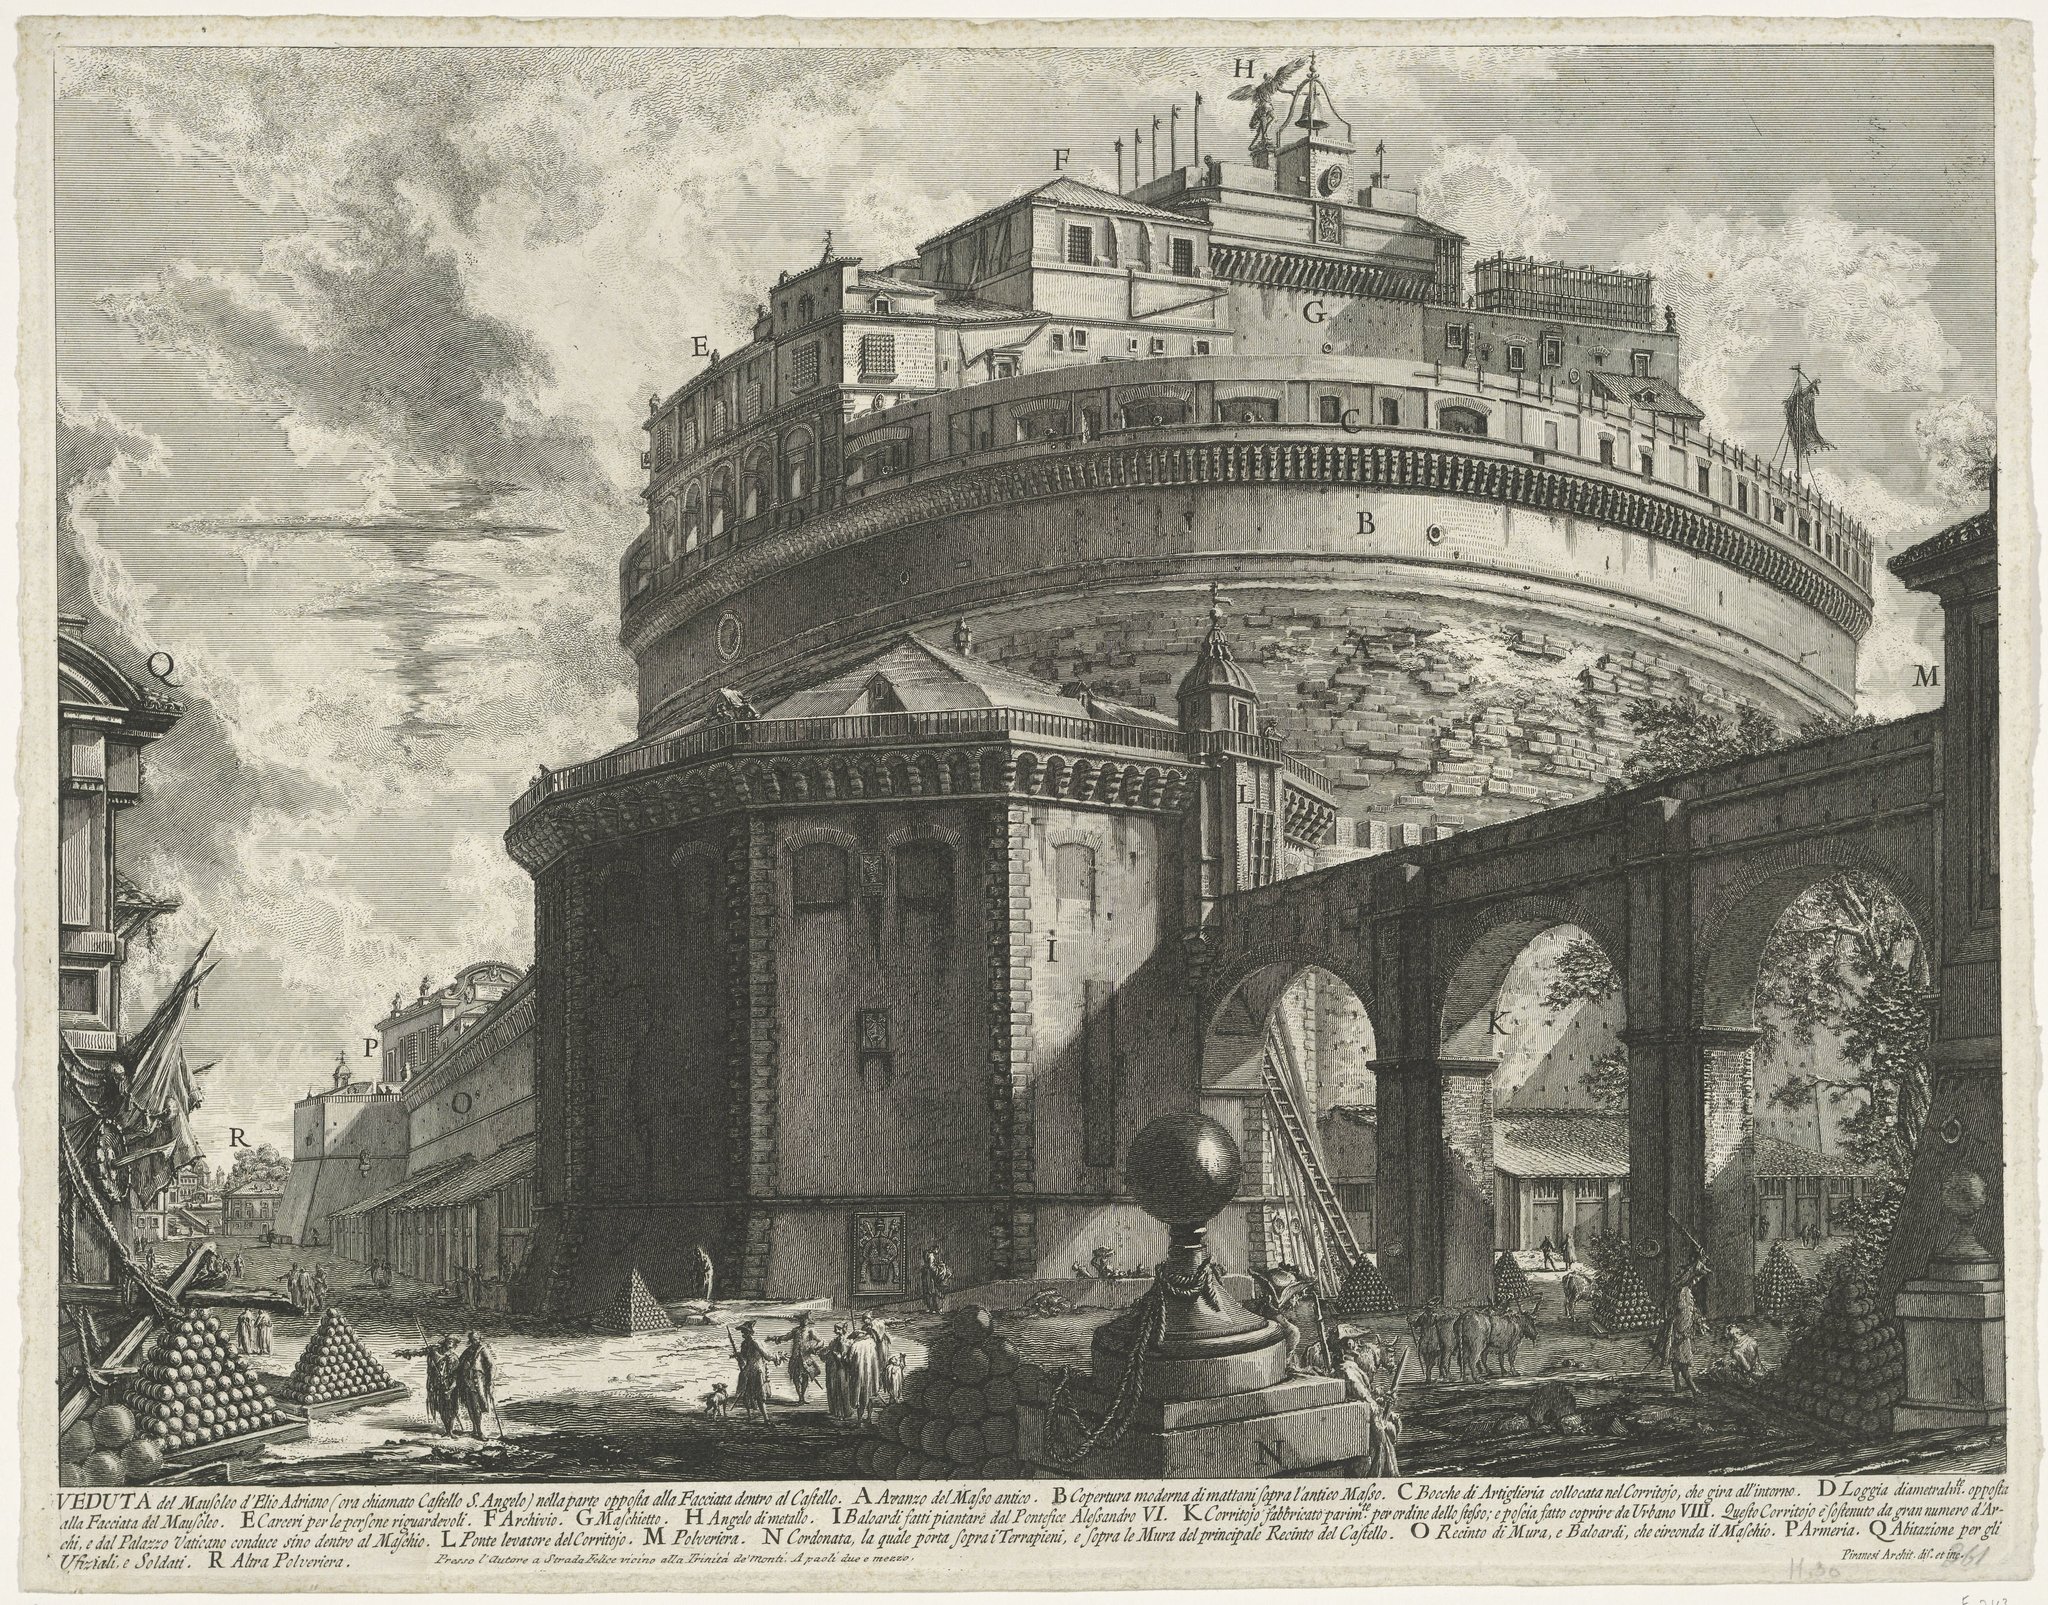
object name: print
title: Engelenburcht te Rome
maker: giovanni battista piranesi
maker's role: designer, draughtsman, print maker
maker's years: 1720-1778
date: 1748-1778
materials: paper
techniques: etching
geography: rome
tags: city-view, and landscape with man-made constructions, ass, donkey (+ types and use of conveyance), rome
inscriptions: collector's mark: Lugt 2228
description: Deze prent maakt deel uit van de serie 'Vedute di Roma'. Piranesi werkte aan deze 135 platen tellende serie tussen 1748 en zijn dood in 1778. Francesco Piranesi voegde later nog twee prenten toe aan de reeks van zijn vader.